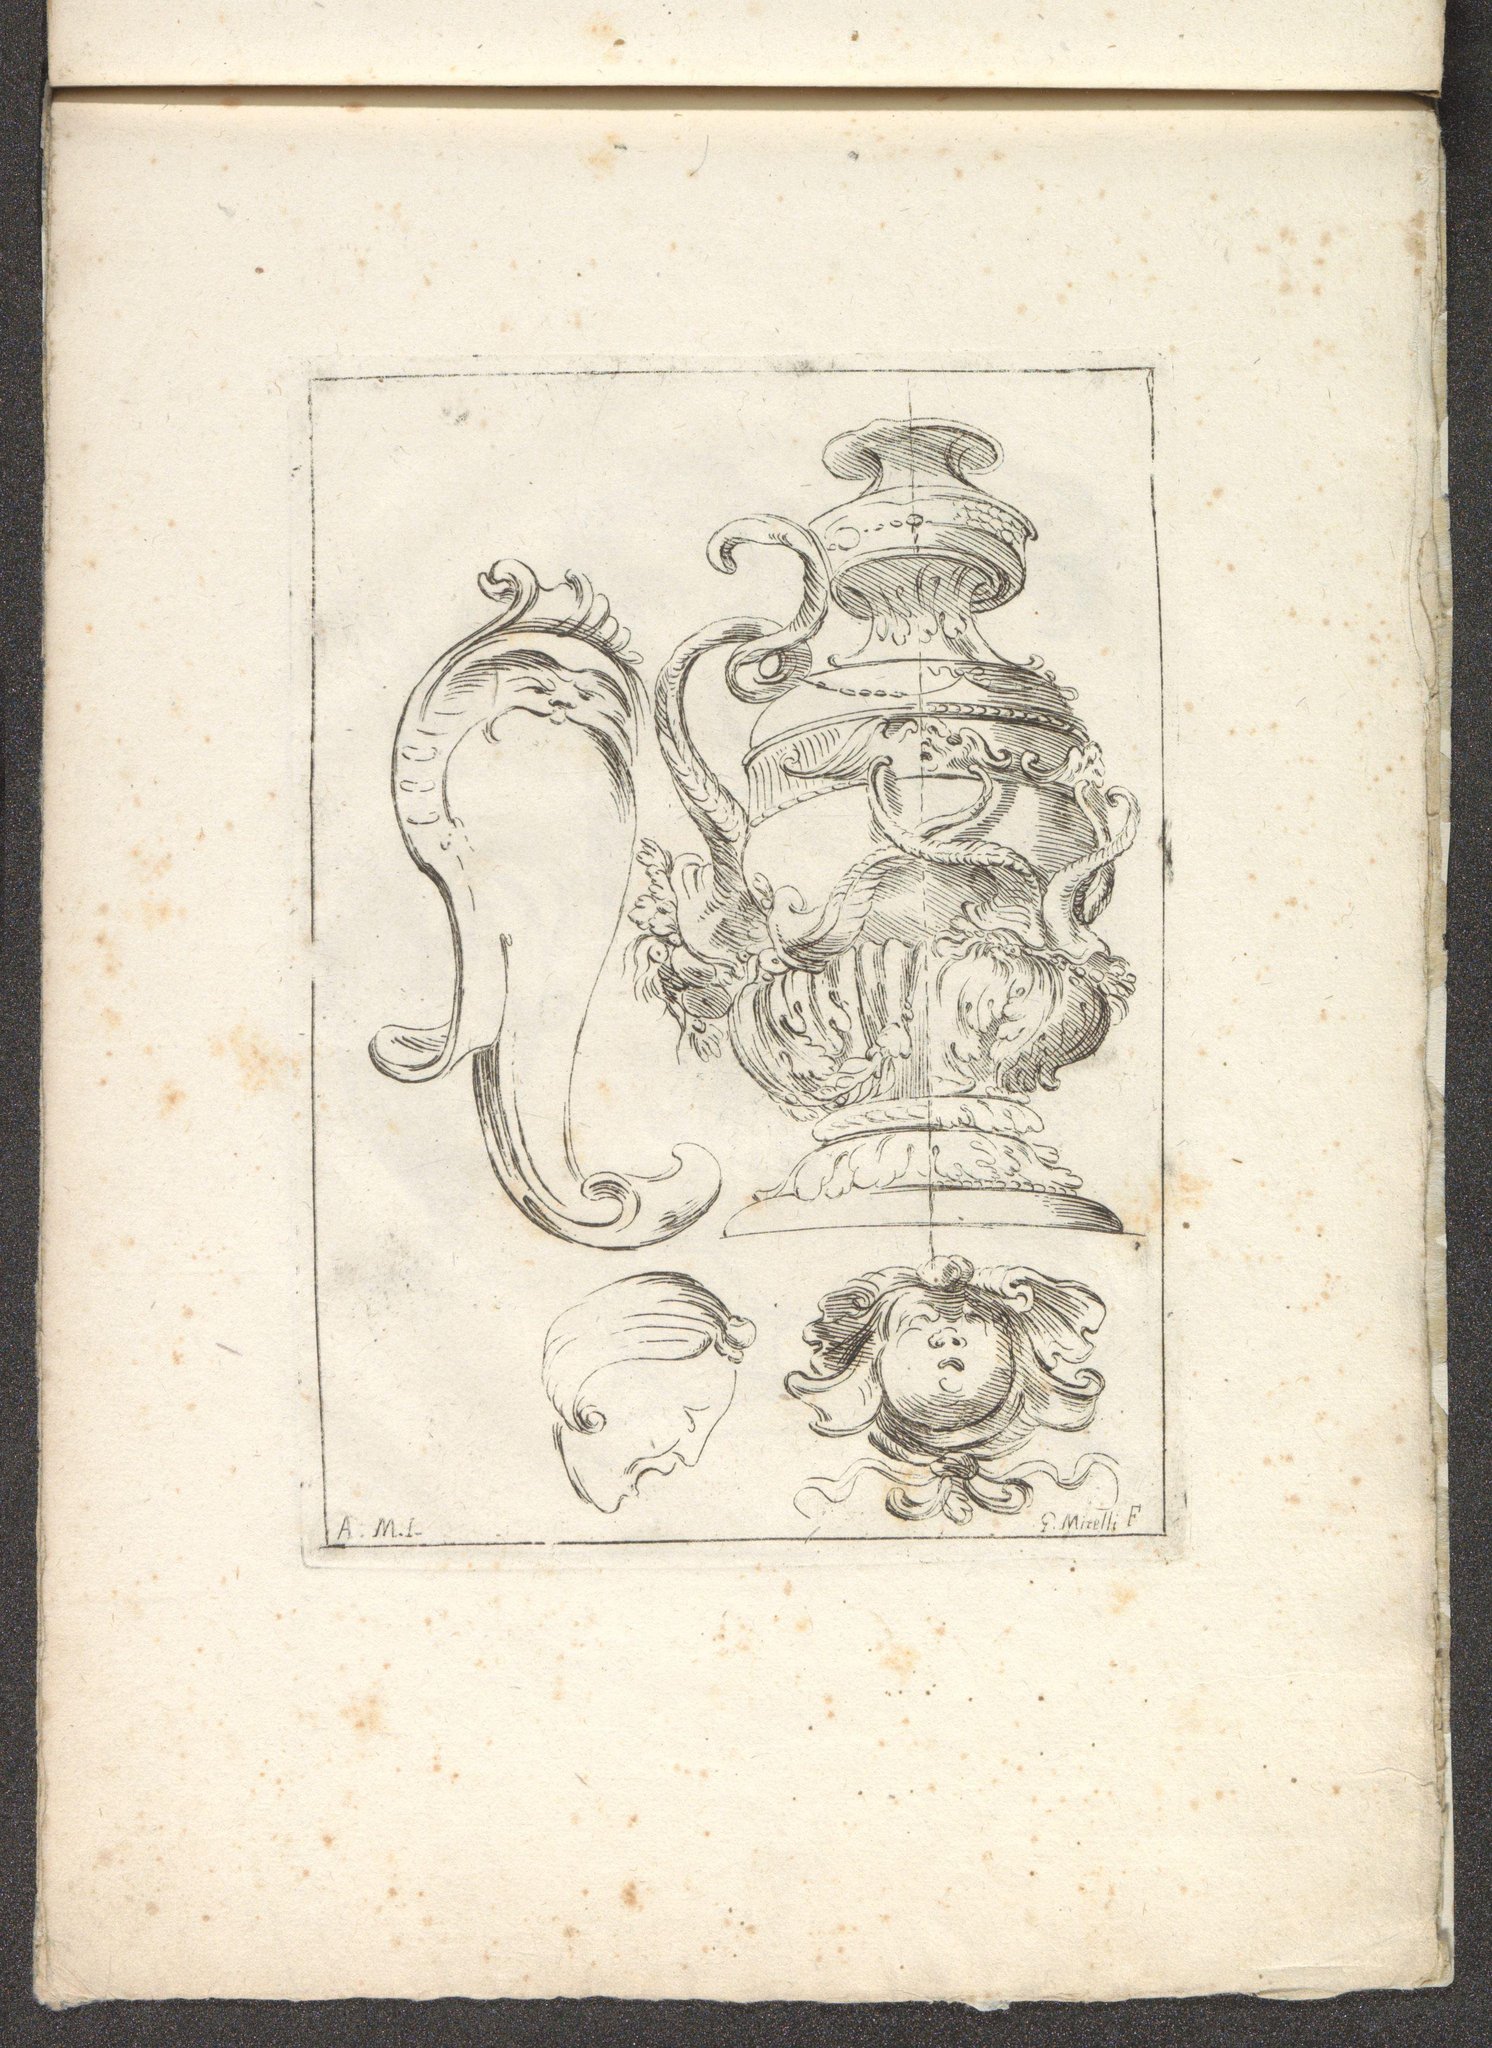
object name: album leaf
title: Disegni, et Abbozzi di Agostino Mitelli Intagliati Dal Figluolo di Lui Gioseppe Maria Mitelli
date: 1644-1718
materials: paper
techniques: etching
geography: italy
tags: ornaments ~ art, vase ~ ornament, ornament ~ cartouche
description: Twee ornamentkoppen, een ornamentele vaas en een cartouche. De prent maakt deel uit van een album.